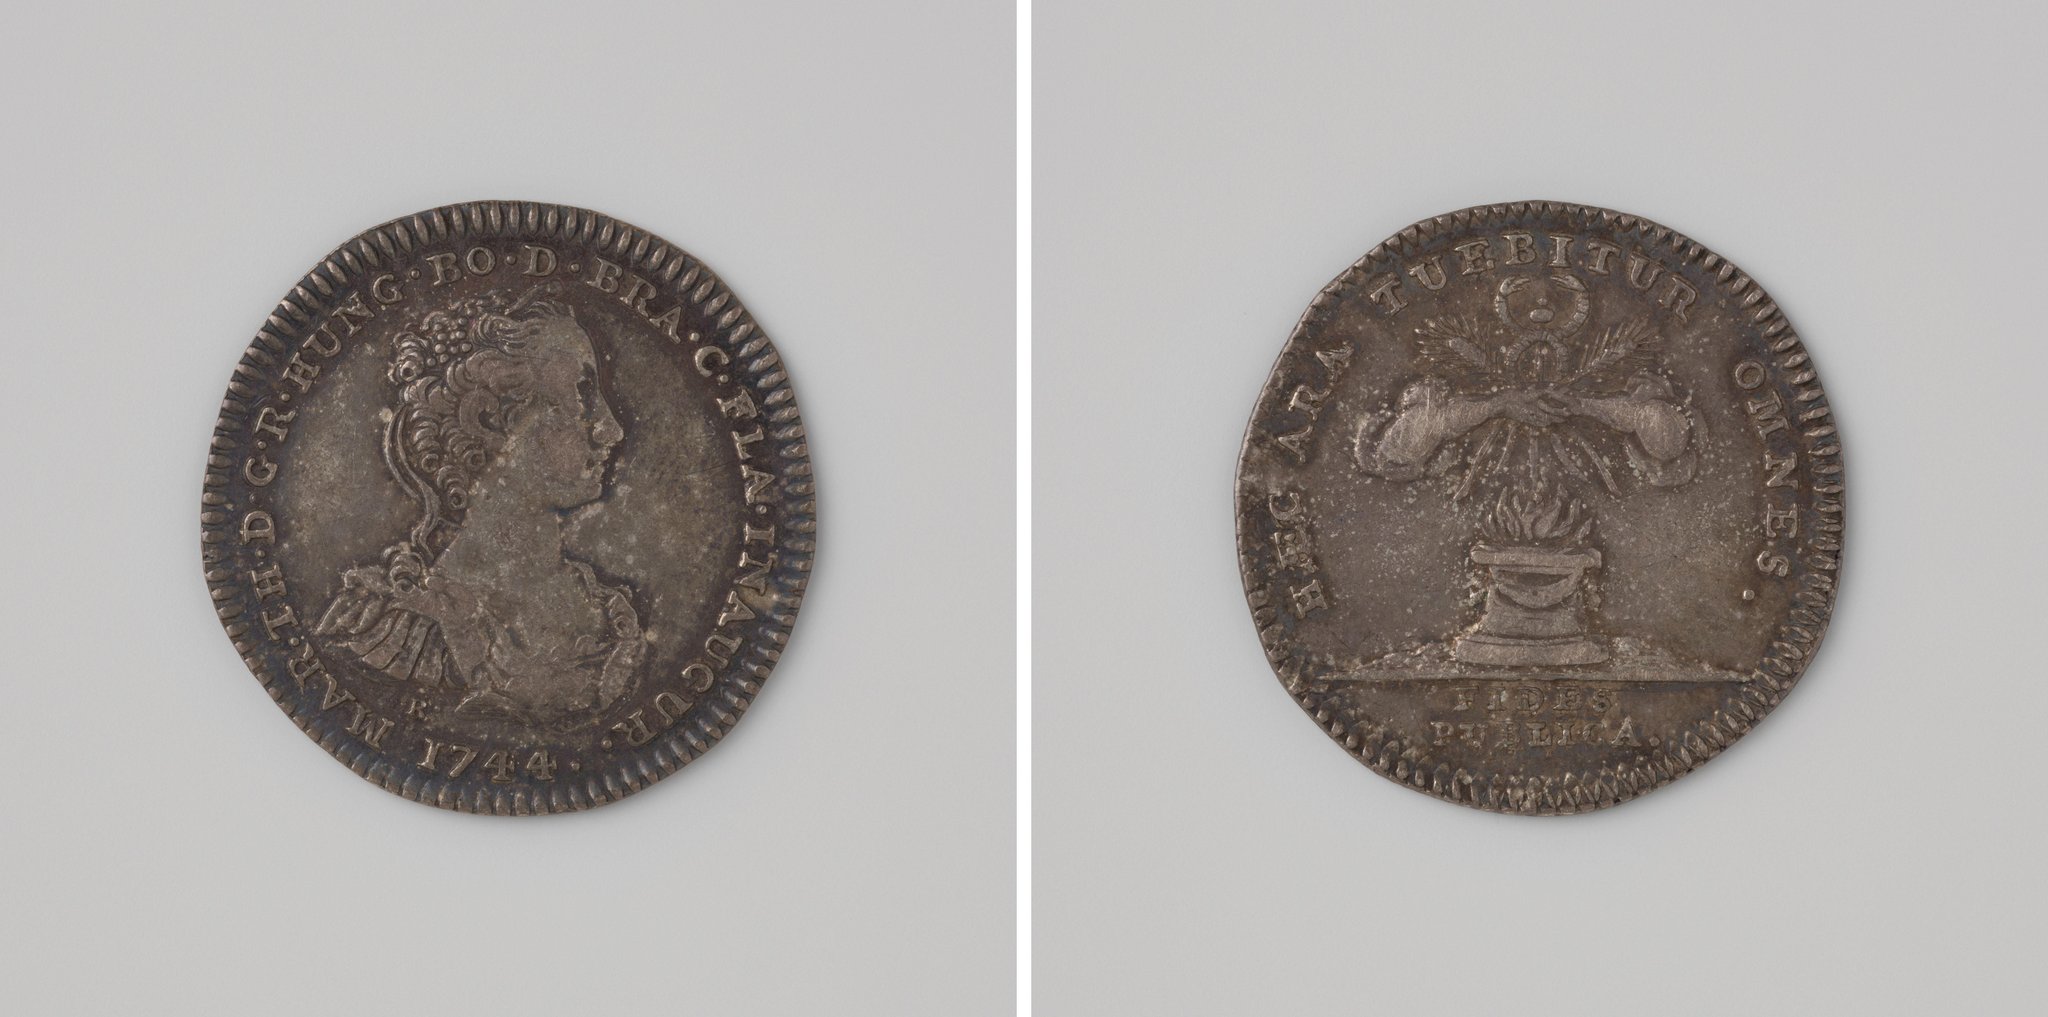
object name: jeton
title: Inhuldiging van Maria Theresia als gravin van Brabant en Vlaanderen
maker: jacques roëttiers (ii)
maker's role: medailleur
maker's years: 1698-1772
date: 1744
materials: silver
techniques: striking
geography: antwerp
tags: vienna, maria theresia (rooms-duits keizerin), brabant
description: Zilveren penning. Voorzijde: borststuk vrouw met diadeem binnen omschrift. Keerzijde: twee ineengeslagen handen uit wolken houden Mercuriusstaf en twee korenaren boven brandend altaar binnen omschrift; afsnede: opschrift